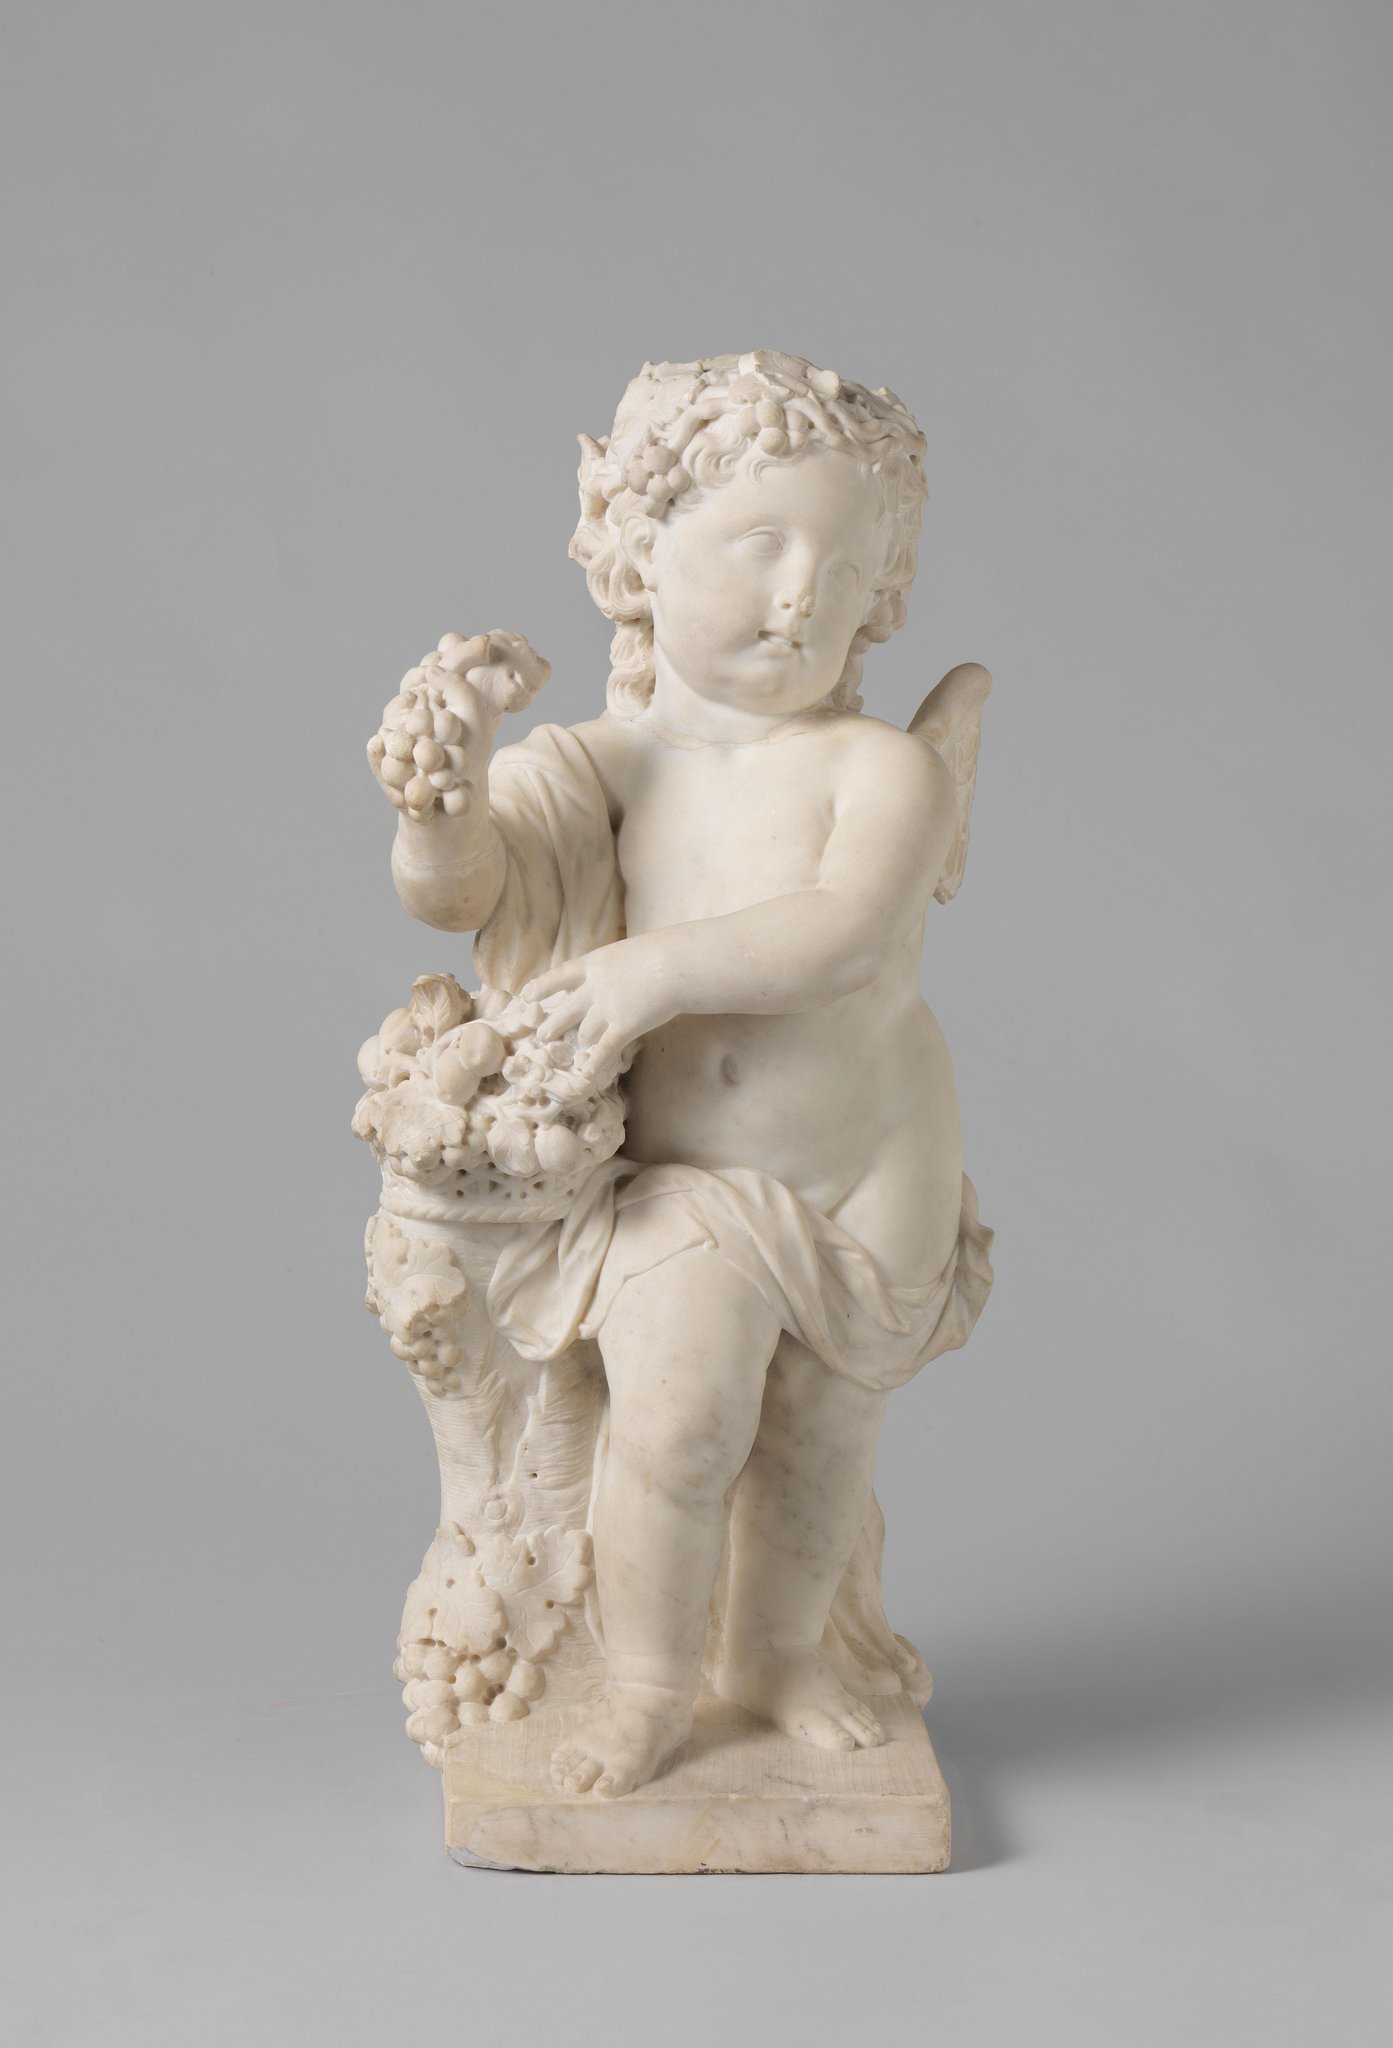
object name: sculpture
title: Winged Putto Personifying Autumn (Bacchus)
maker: ignatius van logteren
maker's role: sculptor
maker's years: 1685-1732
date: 1717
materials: marble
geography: amsterdam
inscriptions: signature, right side of the plinth, incised: ‘I.V.Logteren A° 1717.’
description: Ignatius van Logteren (1685 - 1732). Bacchus as a boy: Autumn. Marble. Amsterdam, 1717.